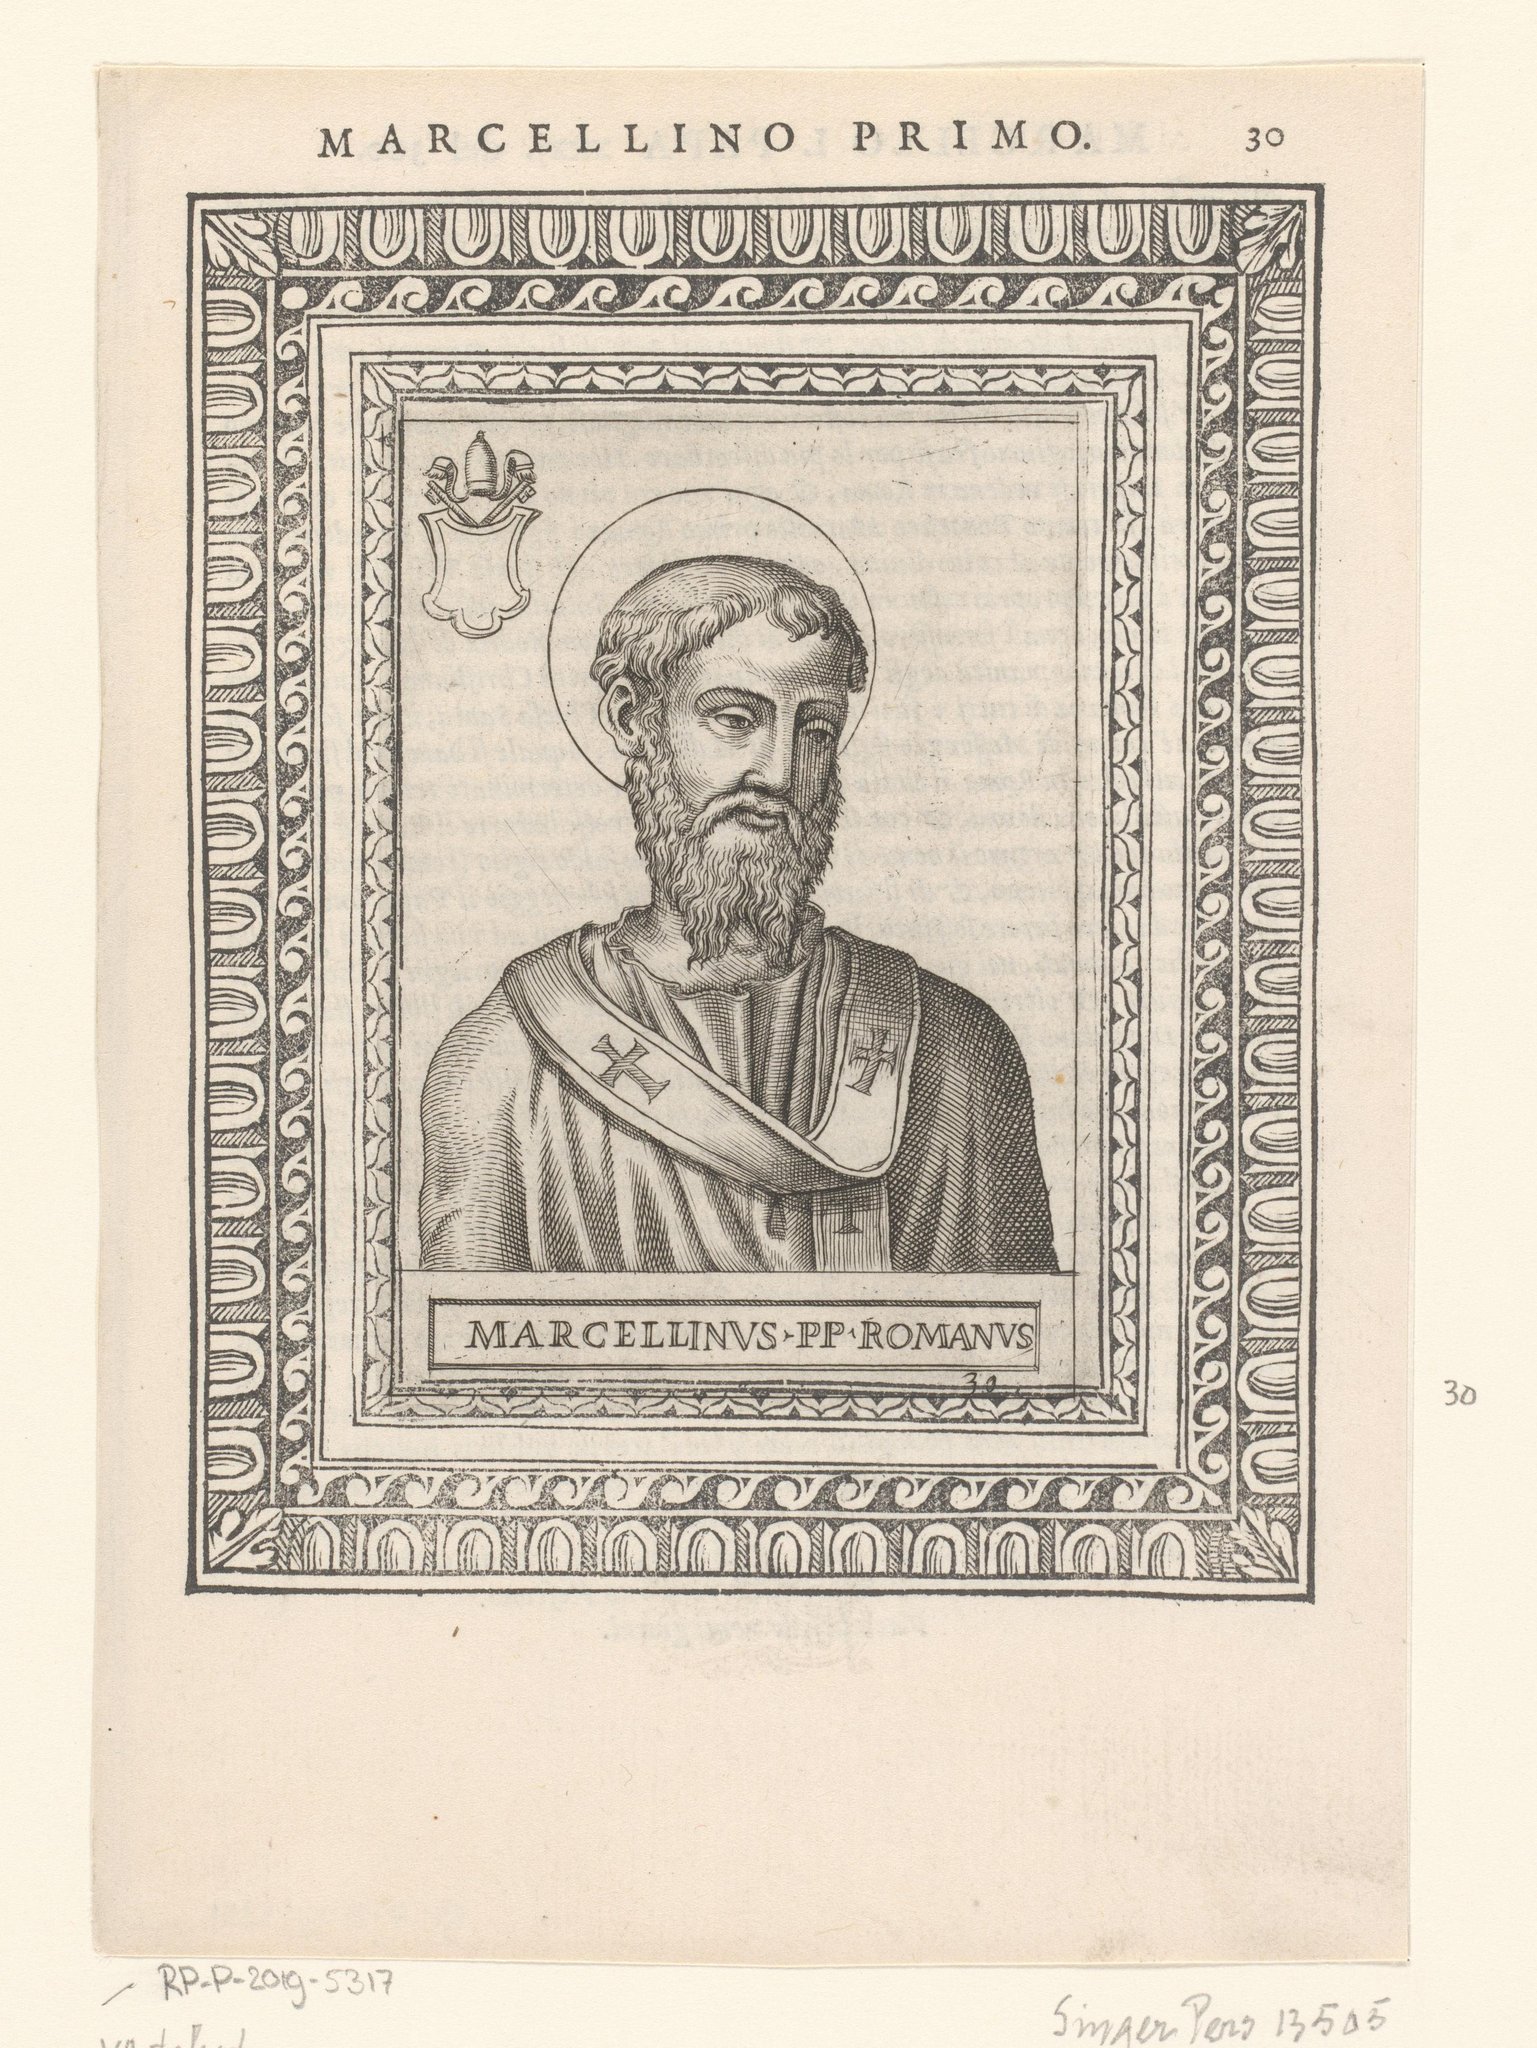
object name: print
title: Marcellinus PP Romanus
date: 1587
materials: paper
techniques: engraving, letterpress printing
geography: rome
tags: historical persons, pope, armorial bearing, heraldry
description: Prent uit: Ciccarelli, Antonio. Le vite de Pontefici di Antonio Ciccarelli (...). Rome: Domenico Basa, 1587. Prent voor het eerst verschenen in: Cavalieri, Giovanni Battista de'. Pontificum romanorum effigies (...). Rome: Domenico Basa en Francesco Zanetti, 1580. Prent ook gebruikt in latere publicaties.